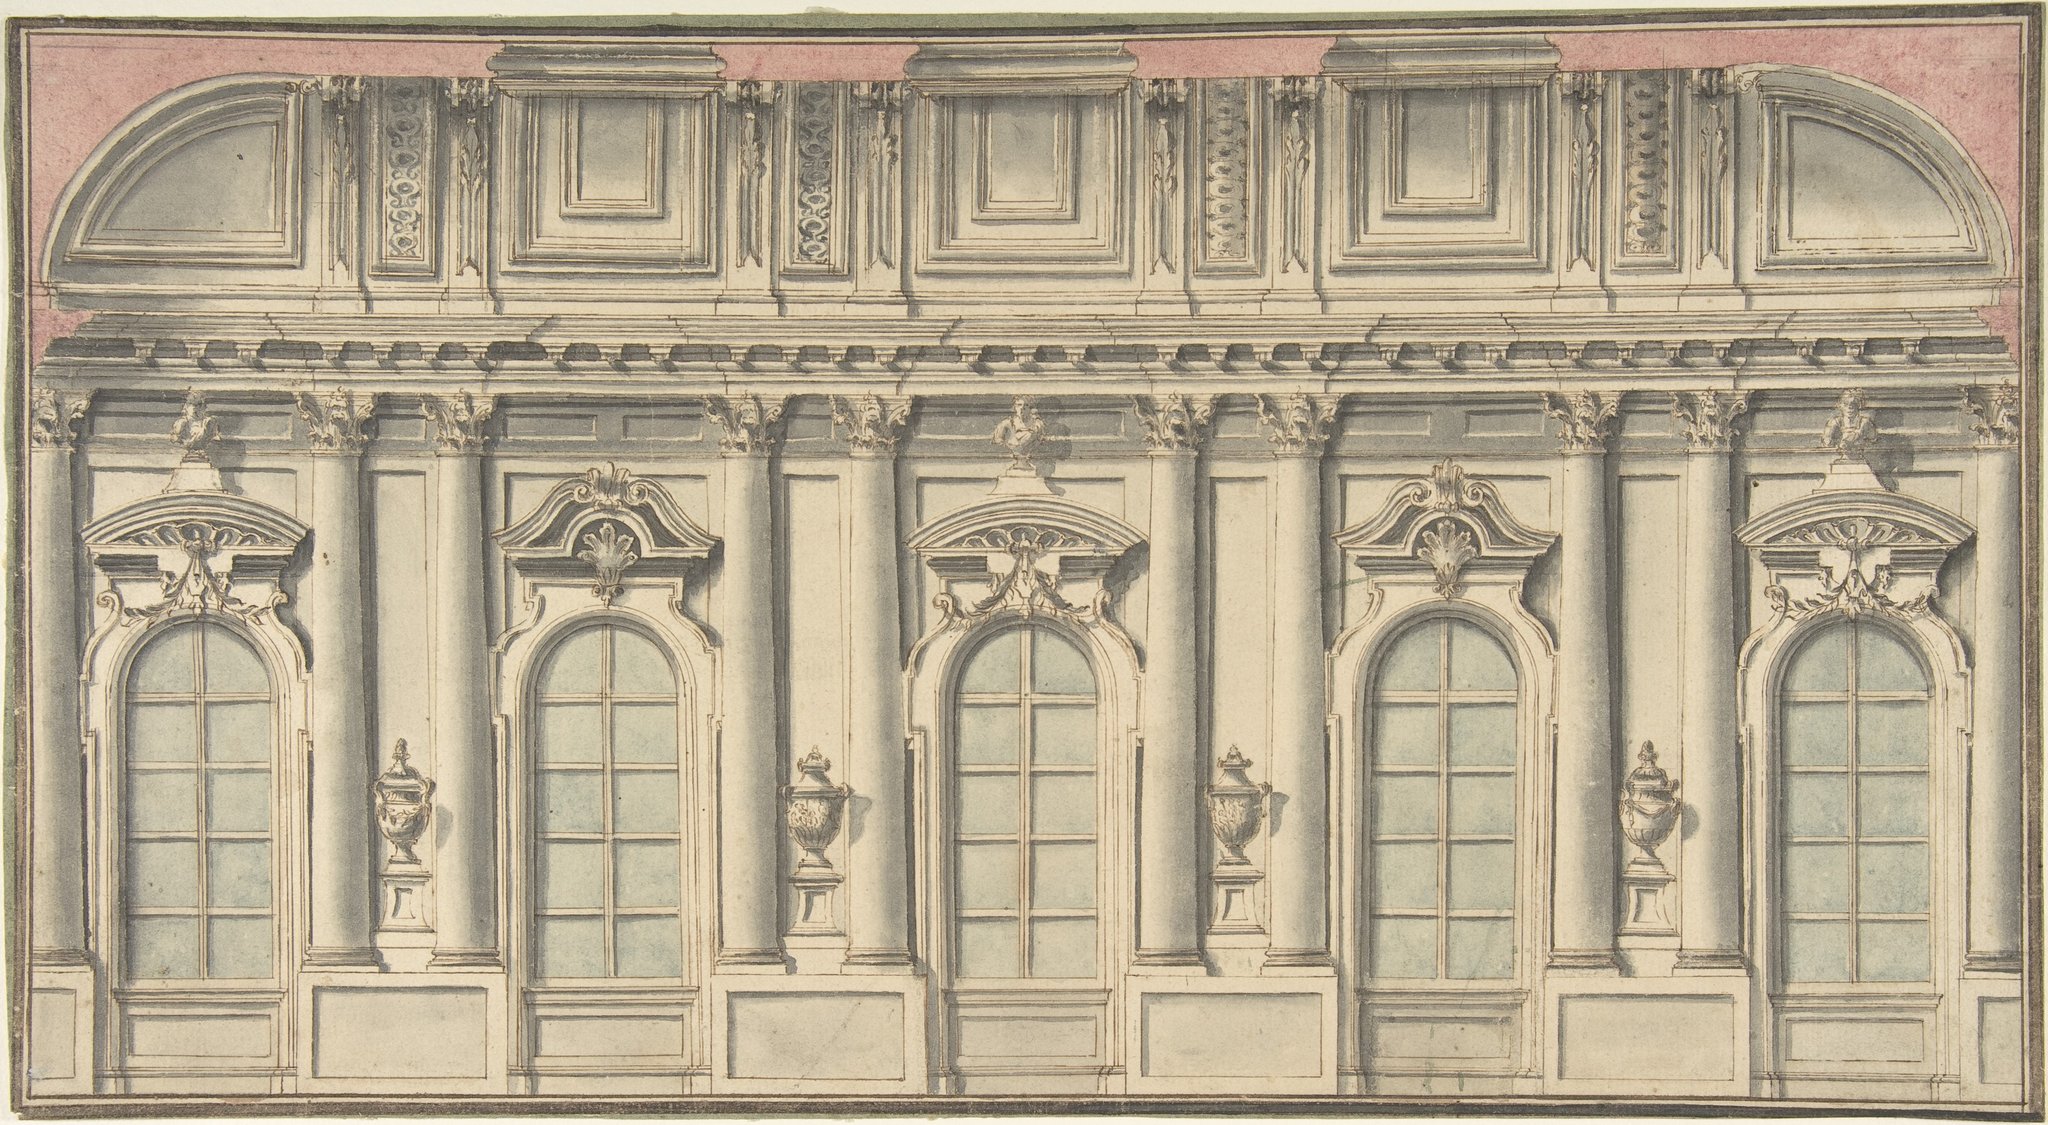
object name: drawing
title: Wall Elevation and Interior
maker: anonymous, italian, 18th century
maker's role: artist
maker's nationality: italian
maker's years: 1700-1800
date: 1701-1800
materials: ink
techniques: pen, wash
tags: architecture,interiors